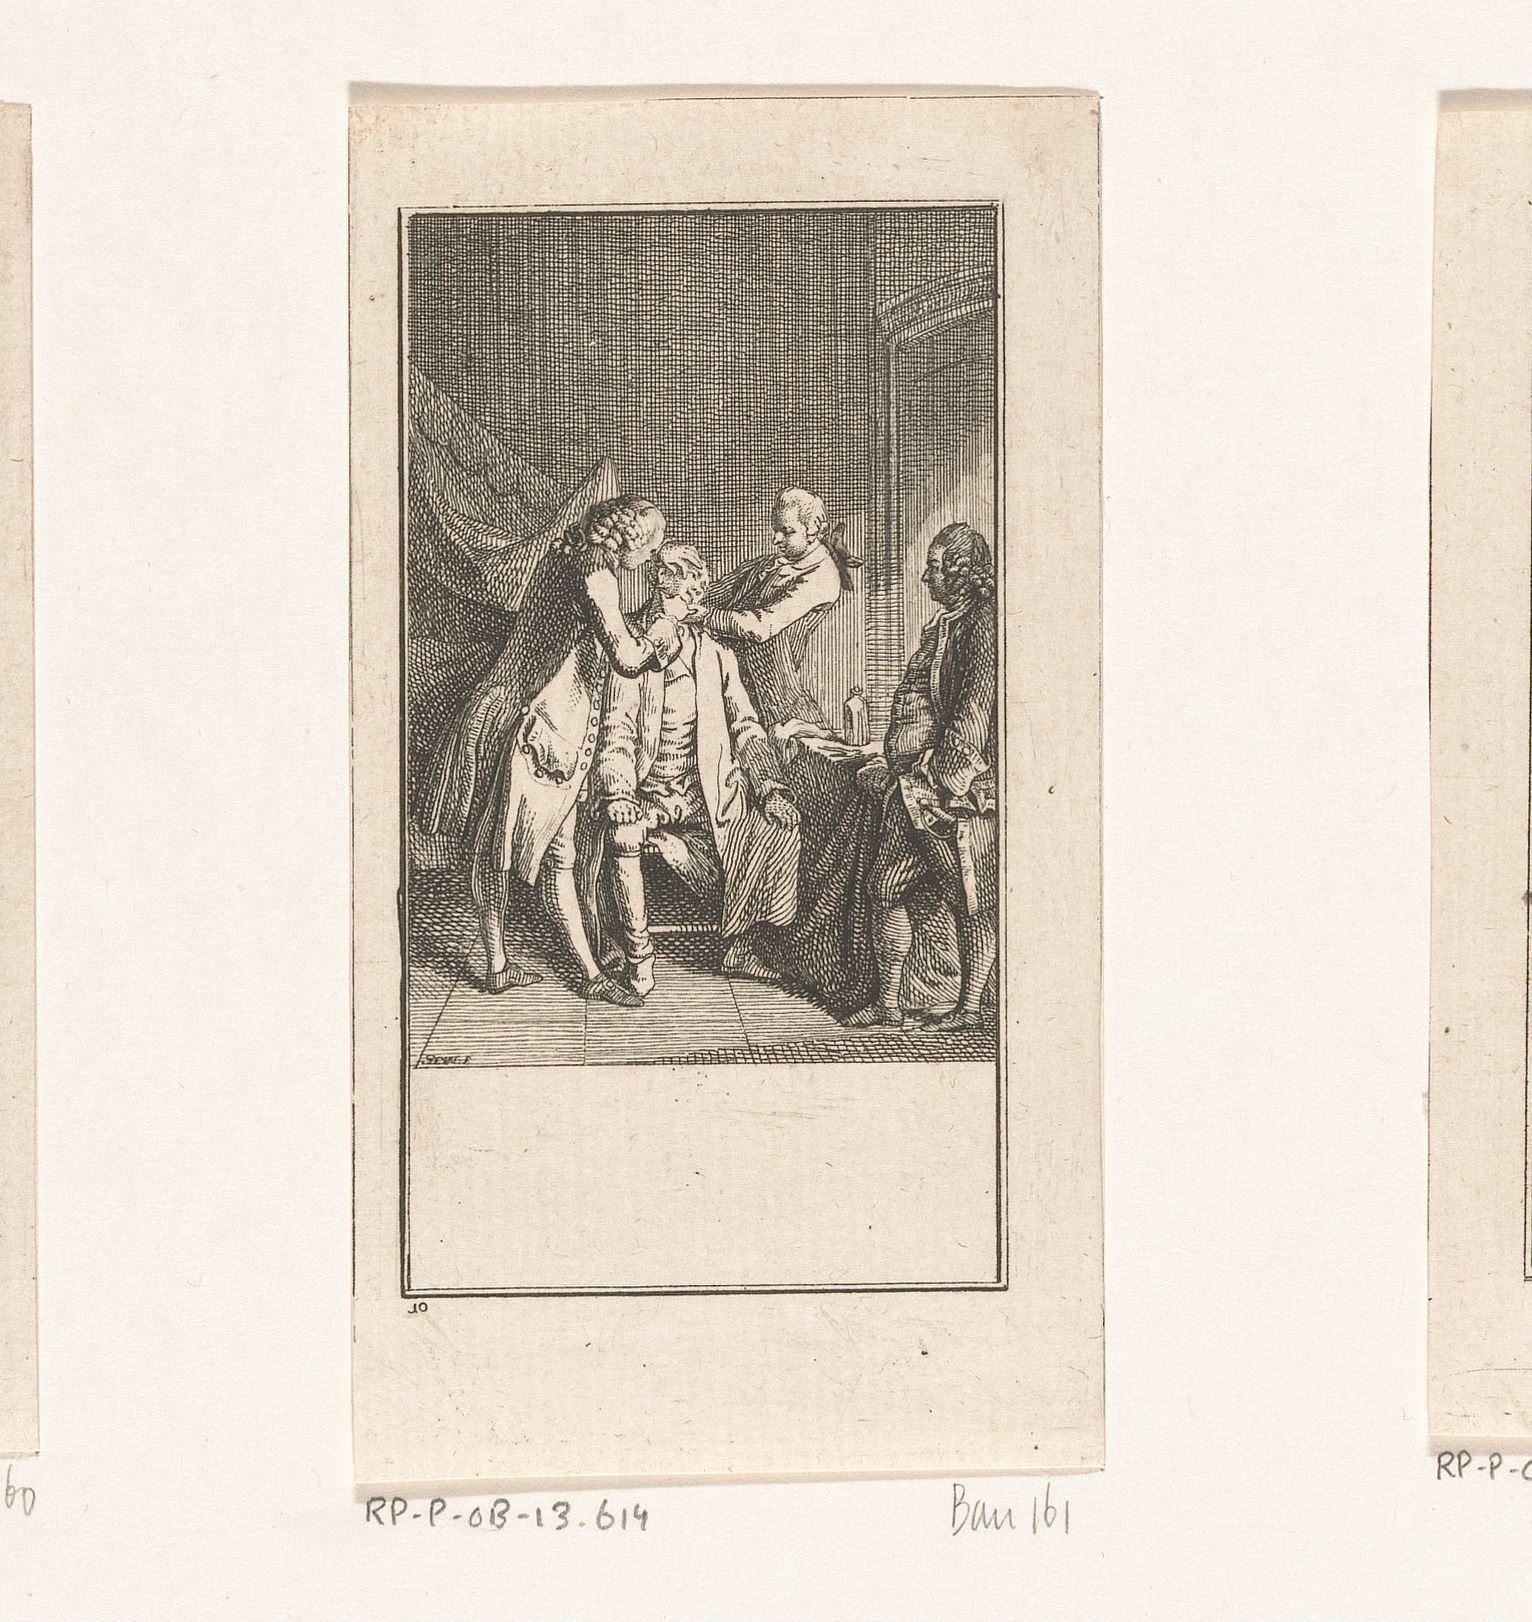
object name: print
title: Folgen der praktische kenntniss der Welt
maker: daniel nikolaus chodowiecki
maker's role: draughtsman, print maker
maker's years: 1726-1801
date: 1773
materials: paper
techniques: etching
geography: berlin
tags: examination, diagnosis; physician speaking with patient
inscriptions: collector's mark: Lugt 2228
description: Tiende prent uit een serie met 12 scènes uit 'een liederlijk leven'. De twaalf scènes werden samen op een plaat geëtst. De tweede staat van deze serie is gebruikt als illustratie in: 'Berliner genealogischen Calender auf das Jahr 1774'. Aan de hand van deze prentserie schreef Johann Christian Ludwig Haken (1767-1835) zijn briefroman 'Der Lüderliche'.